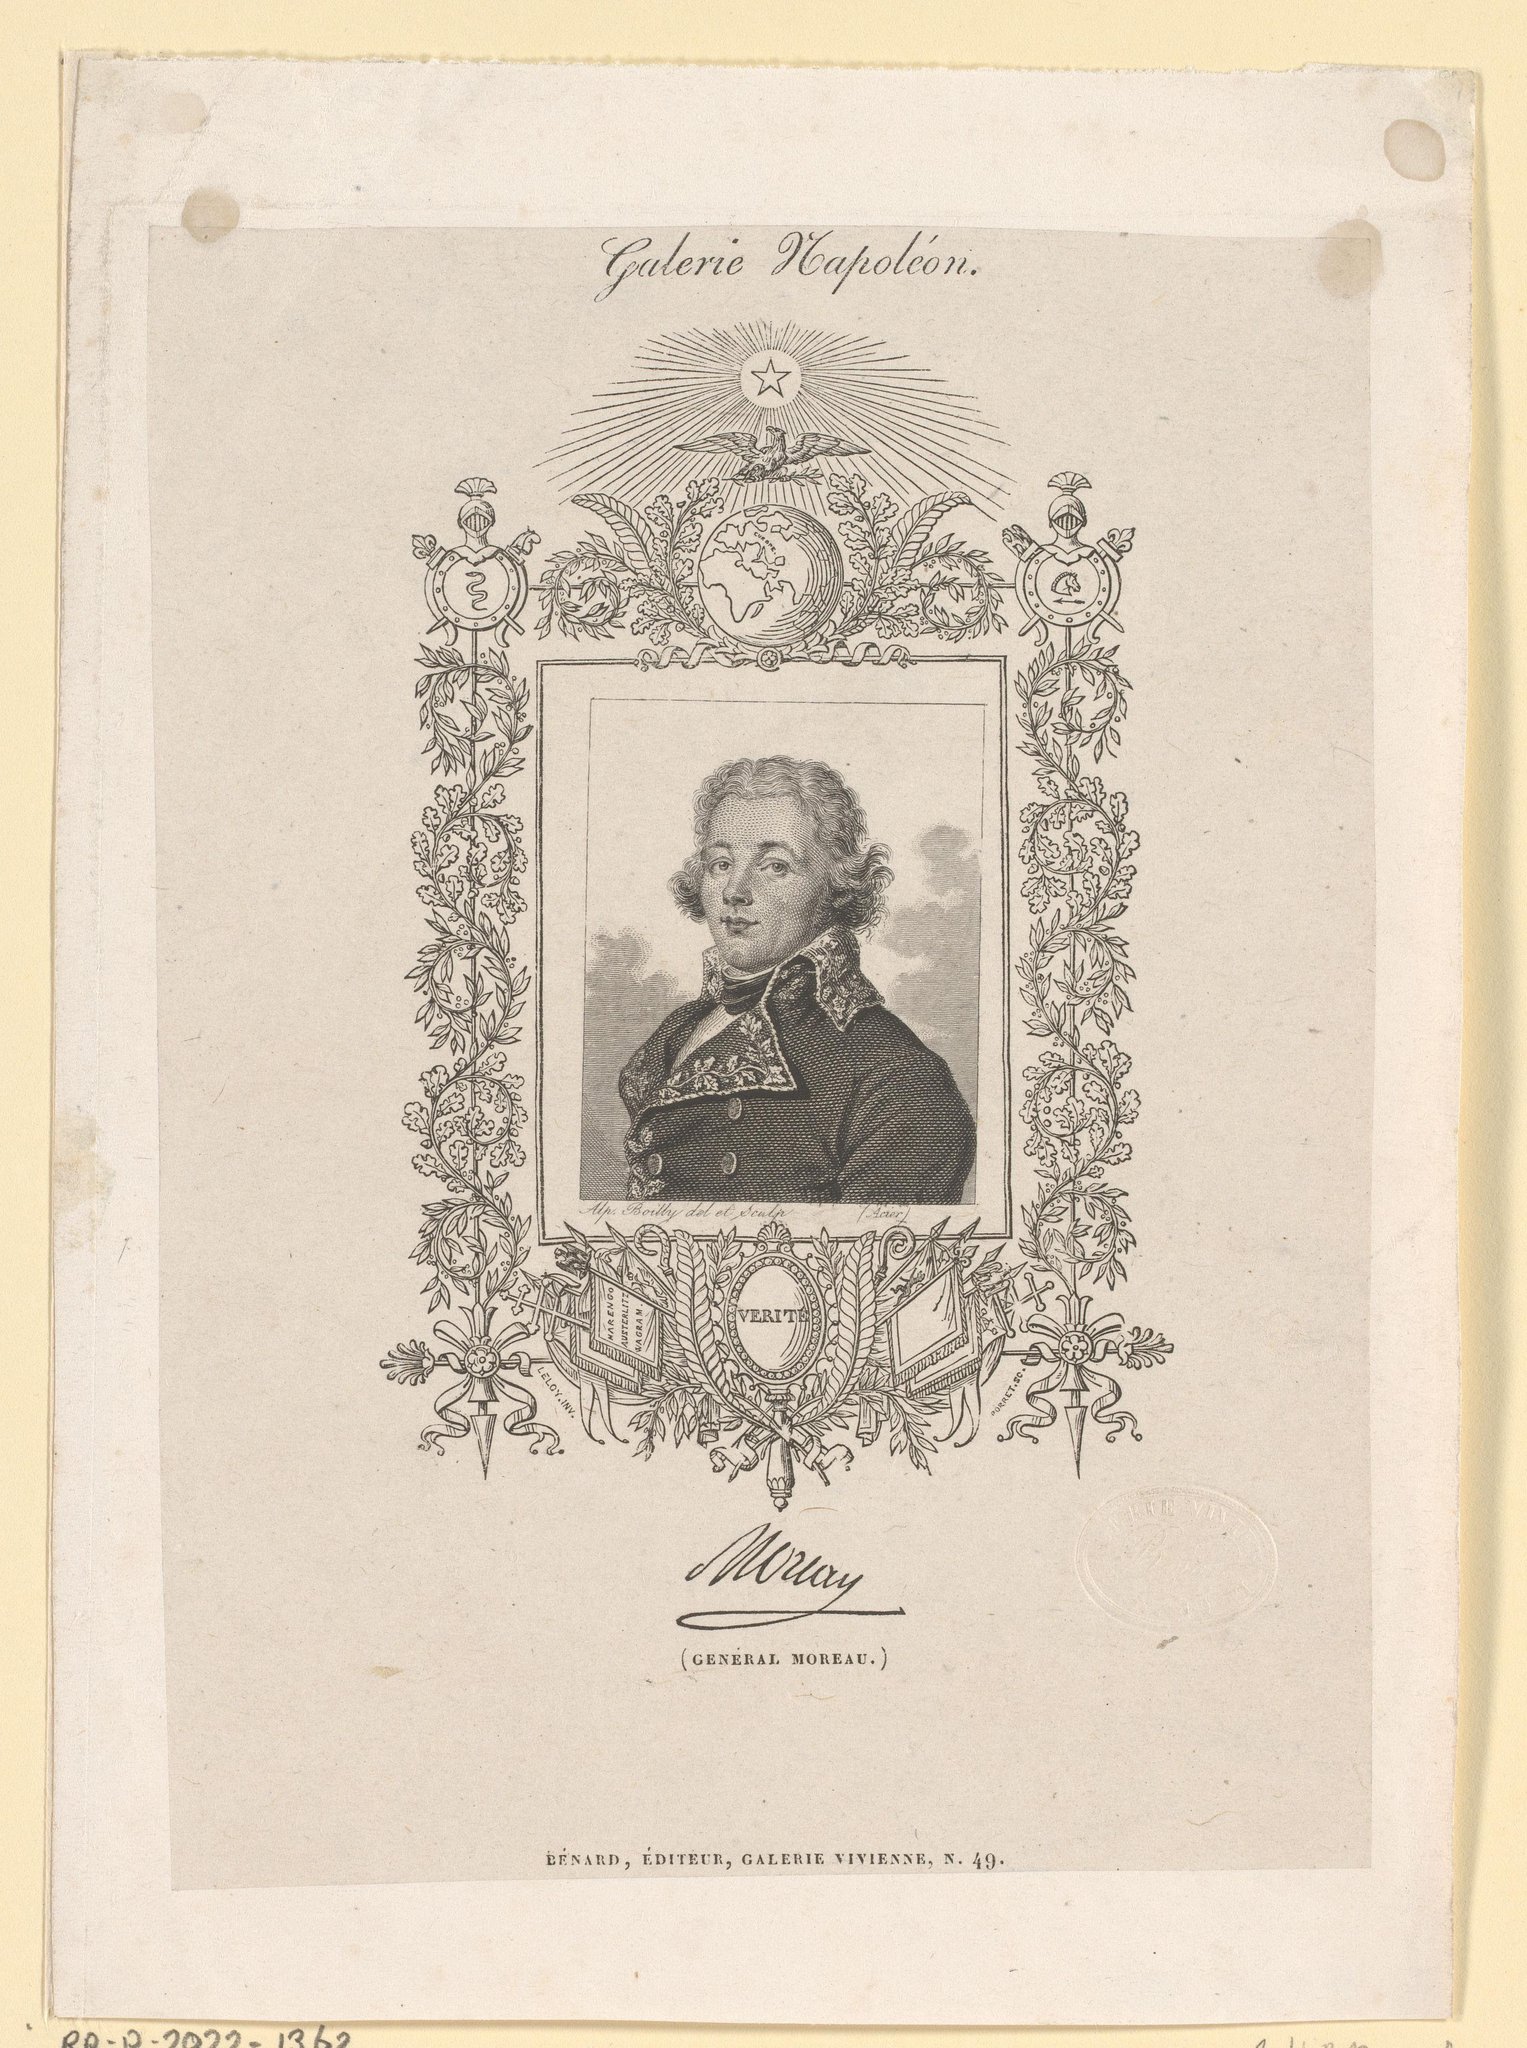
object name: print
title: Galerie Napoléon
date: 1811-1867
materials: paper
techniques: letterpress printing, engraving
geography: paris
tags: commander-in-chief, general, marshal, historical persons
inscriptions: : ‘Galerie Vivienne / Bénard / N. 49’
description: Met facsimile signatuur van de geportretteerde.